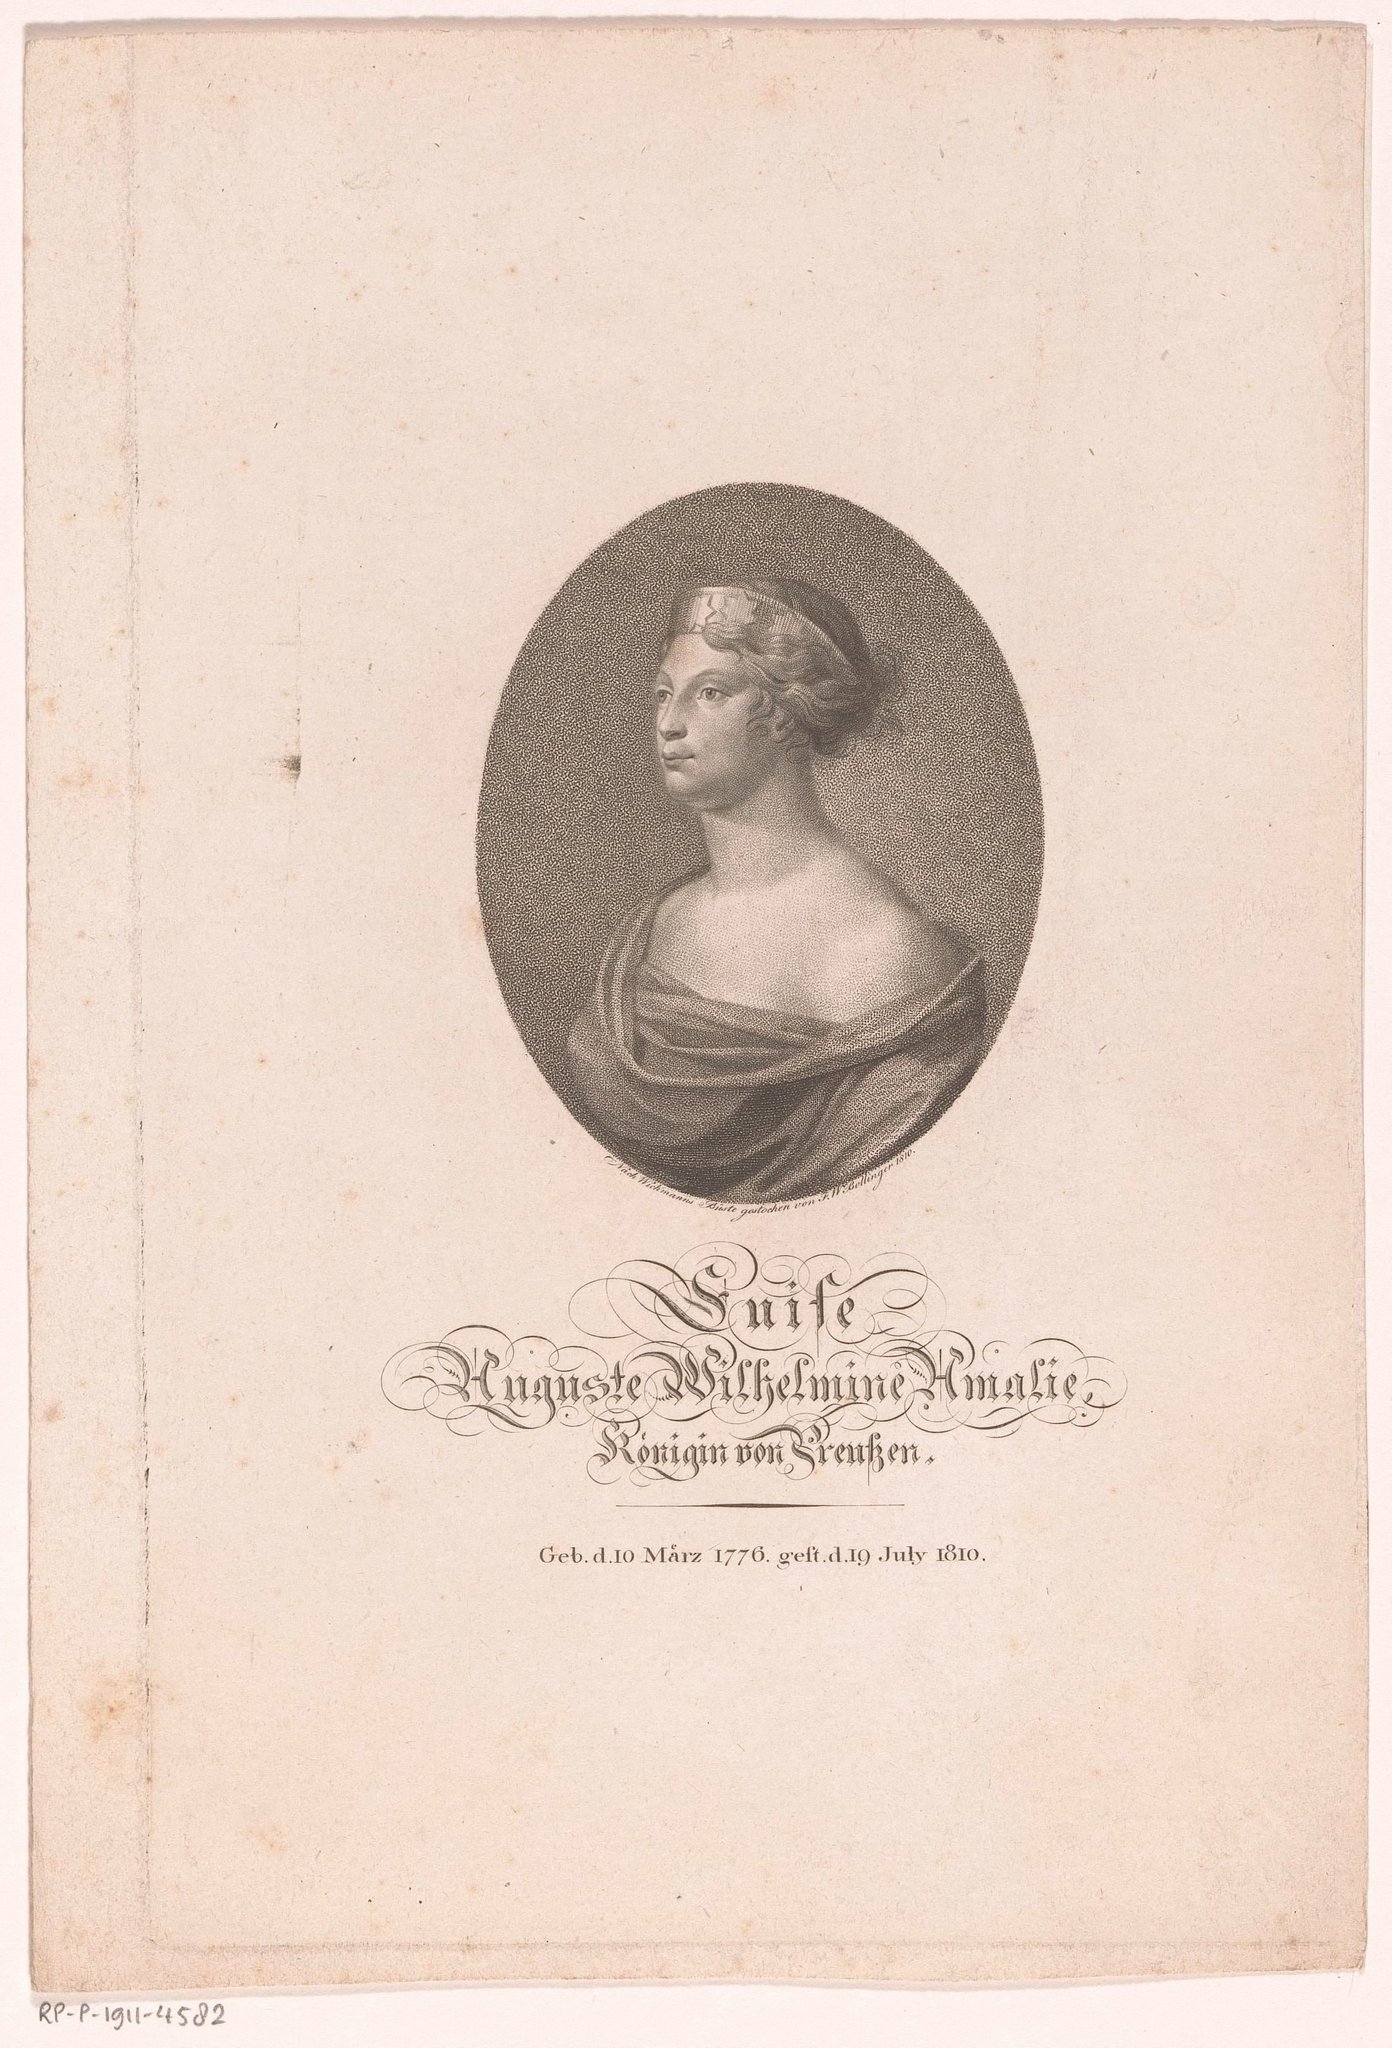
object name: print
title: Portret van Luise von Mecklenburg-Strelitz, koningin van Pruisen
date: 1810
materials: paper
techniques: stippling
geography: berlin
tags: historical persons - bb - woman, diadem, tiara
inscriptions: collector's mark: Lugt 2228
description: Prent ook gebruikt in: Luise August Wilhelmine Amalie, Königinn von Preußen. Ein Denkmal. Berlijn: Friedrich Braunes, 1810.